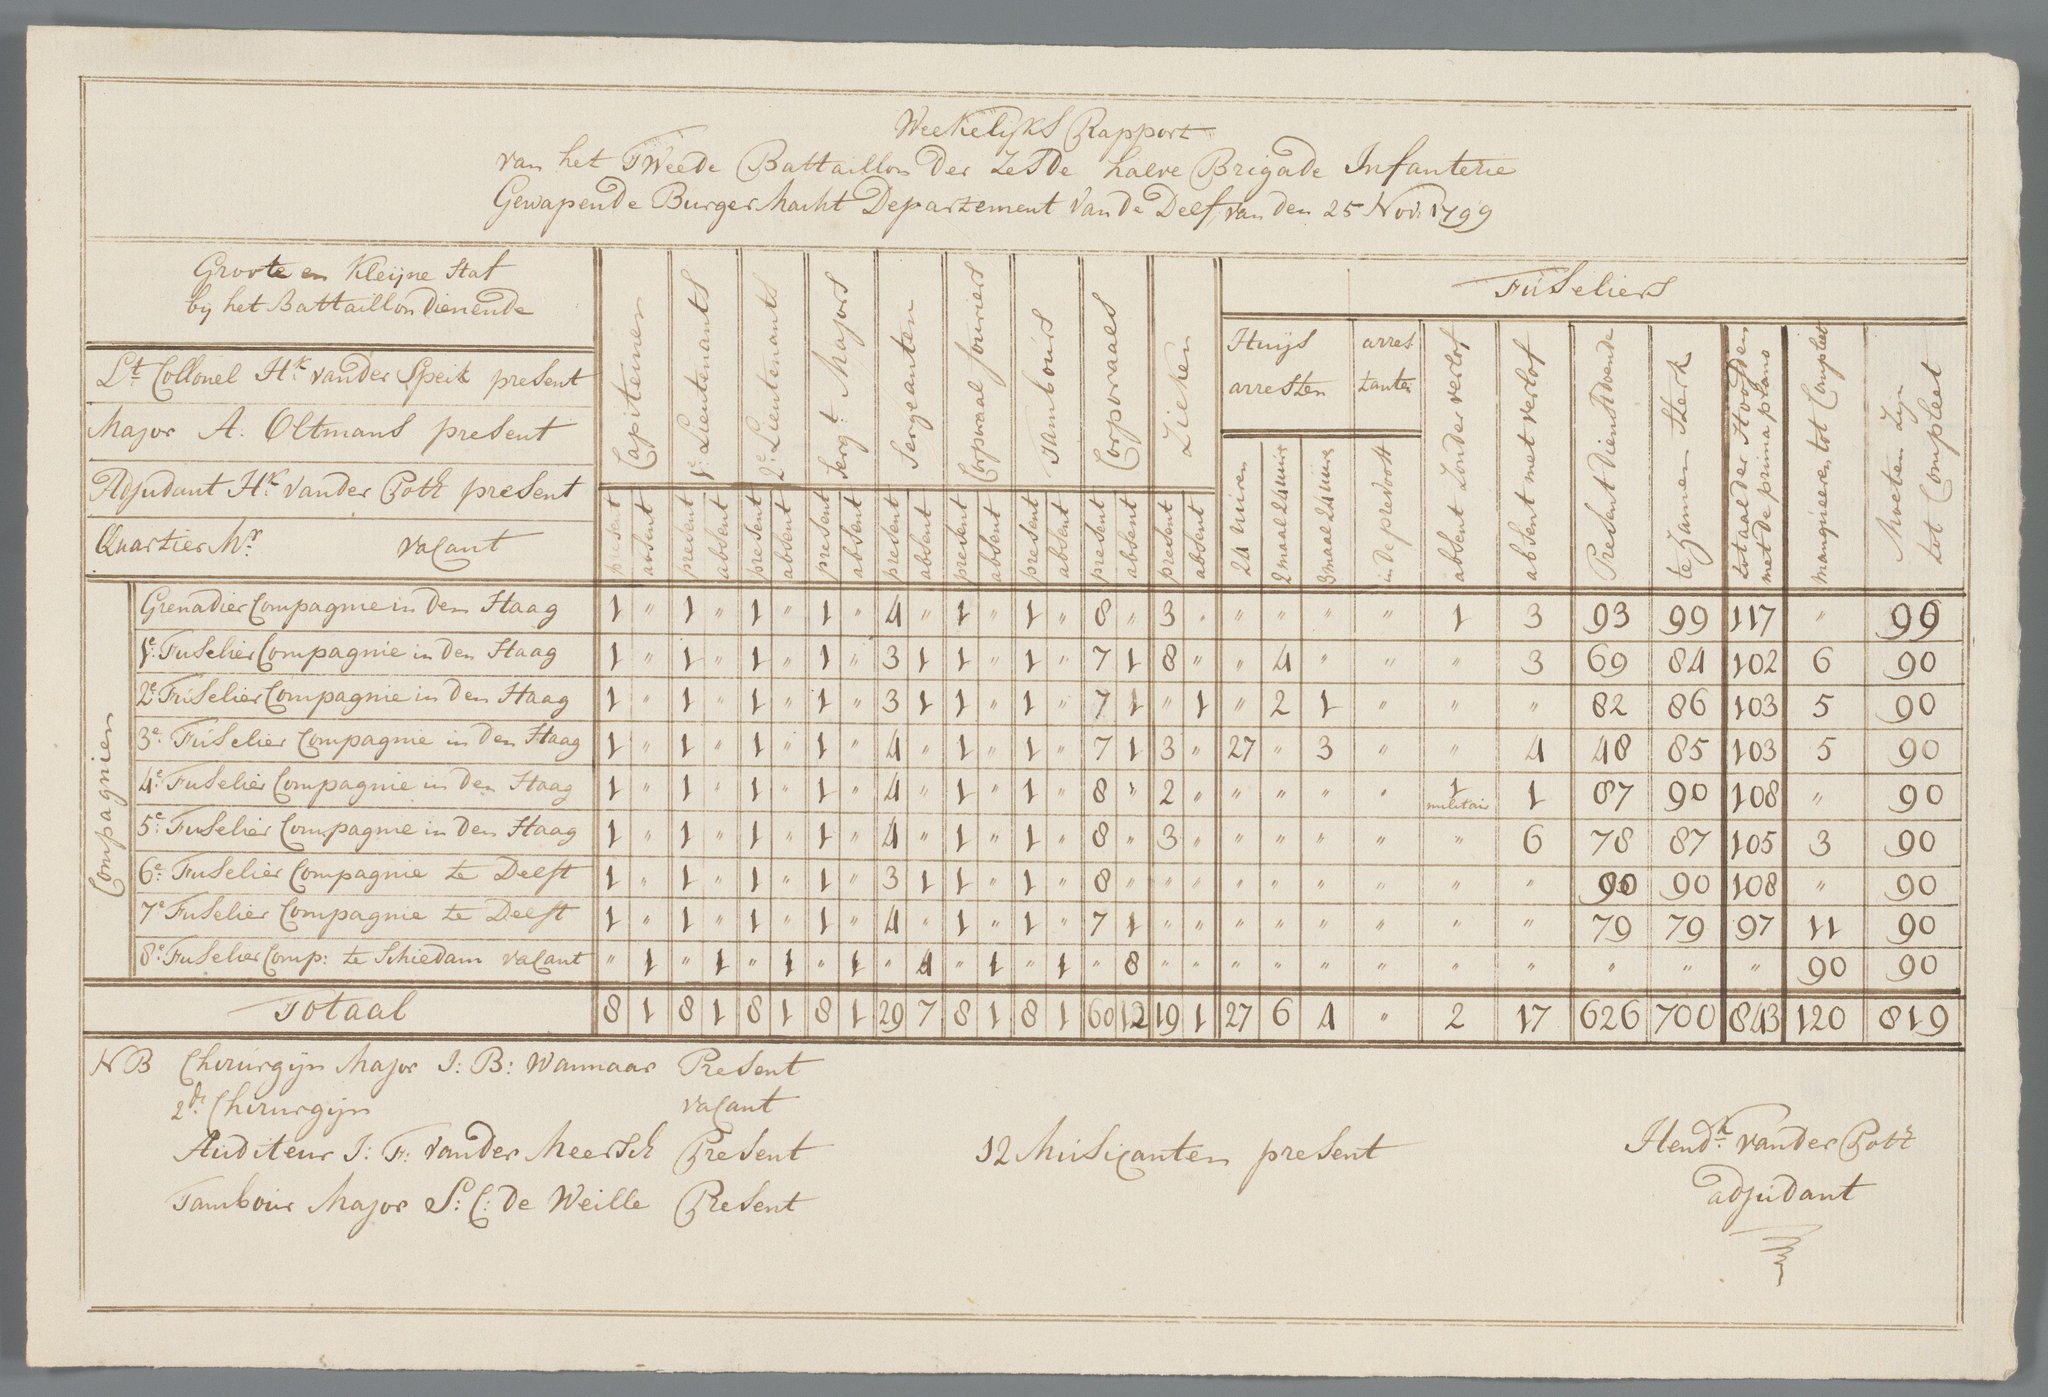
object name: drawing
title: Weekelijks Rapport van het Tweede Battaillon der Zesde halve Brigade Infanterie Gewapende Burgermacht Departement van de Delf van den 25 Nov. 1799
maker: hendrik van der poth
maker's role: draughtsman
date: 1799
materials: paper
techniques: writing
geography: delft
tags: delft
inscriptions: date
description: Blad met wekelijks rapport van het tweede Battaillon der Zesde halve Brigade Infanterie Gewapende Burgermacht van Delft, november 1799. Ten tijde van de Brits-Russische expeditie in 1799.